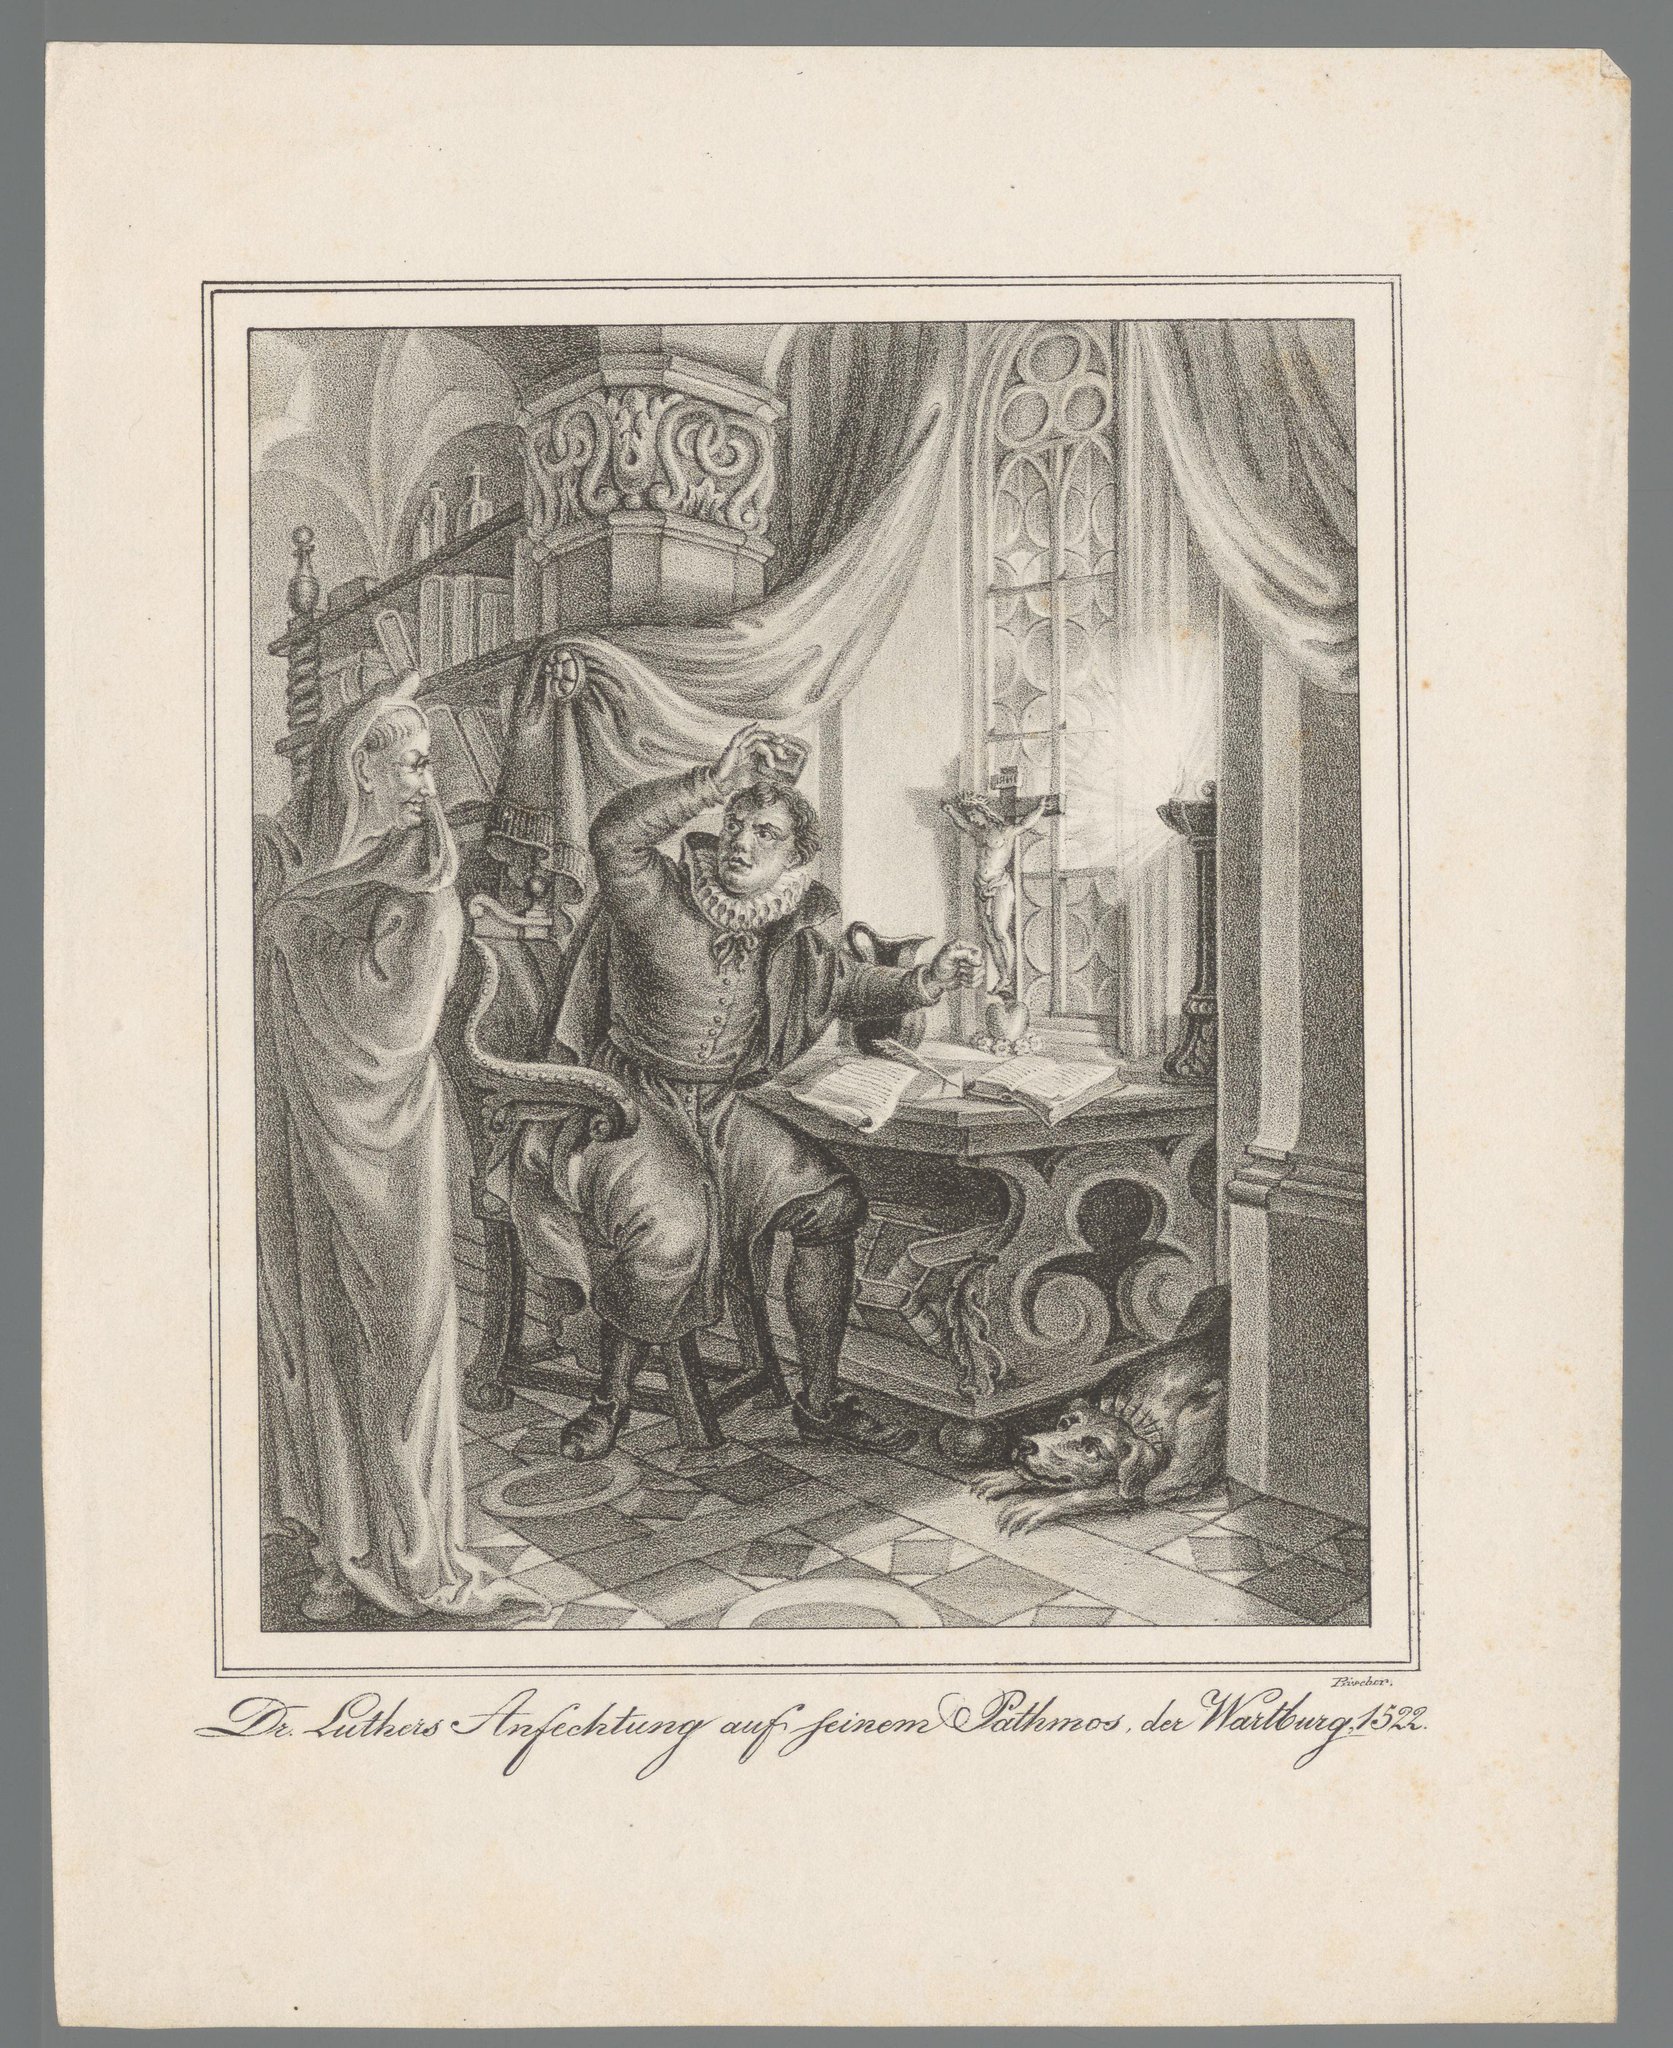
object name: print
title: Martin Luther aan een schrijftafel op de Wartburg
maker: karl dietrich pirscher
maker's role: print maker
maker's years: 1791-1857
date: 1820-1857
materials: paper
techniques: lithograph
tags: priest, martin luther, writing-table, writing-desk, study; 'studiolo'; library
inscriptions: collector's mark: Lugt 2228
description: Luther noemde de Wartburg zijn Patmos, naar het eiland waarnaar de evangelist Johannes werd verbannen.